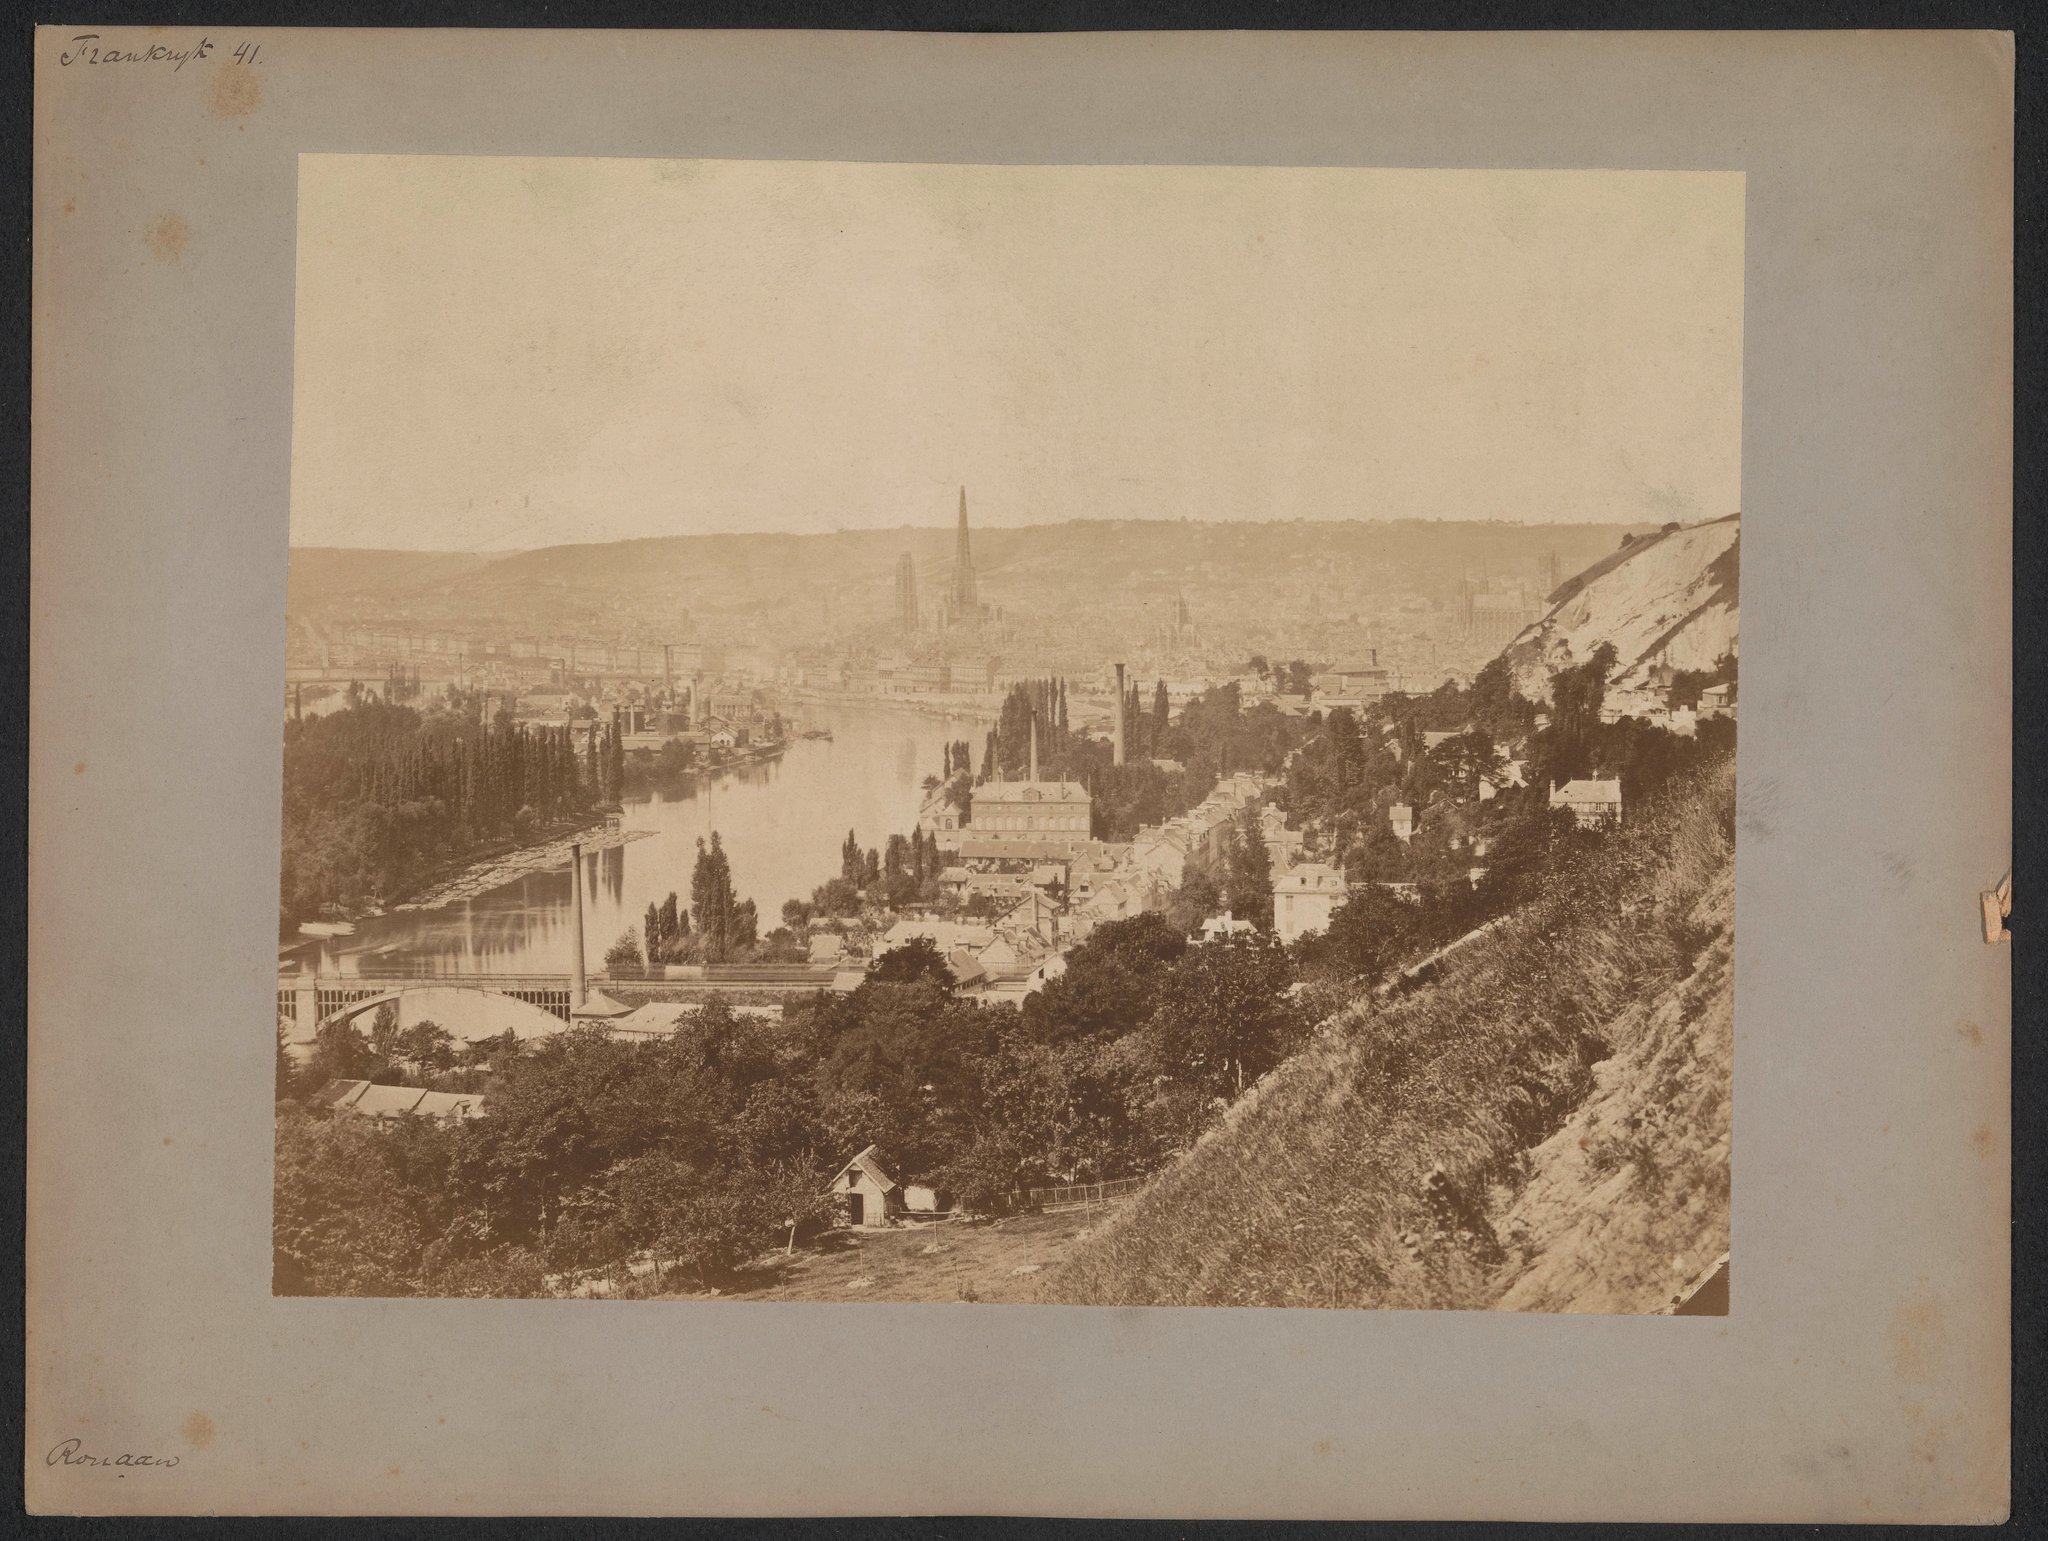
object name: photograph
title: Gezicht op Rouen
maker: Anonymous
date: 1850-1900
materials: cardboard, photographic support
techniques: albumen print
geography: rouen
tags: city-view, and landscape with man-made constructions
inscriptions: annotation: ‘Frankrijk 41.’, annotation: ‘Rouaan’, annotation: ‘Rouen’, collector's mark: ‘RIJKS NORMAALSCHOOL voor T[EEKENONDERWIJZERS] AMSTERD[AM]’